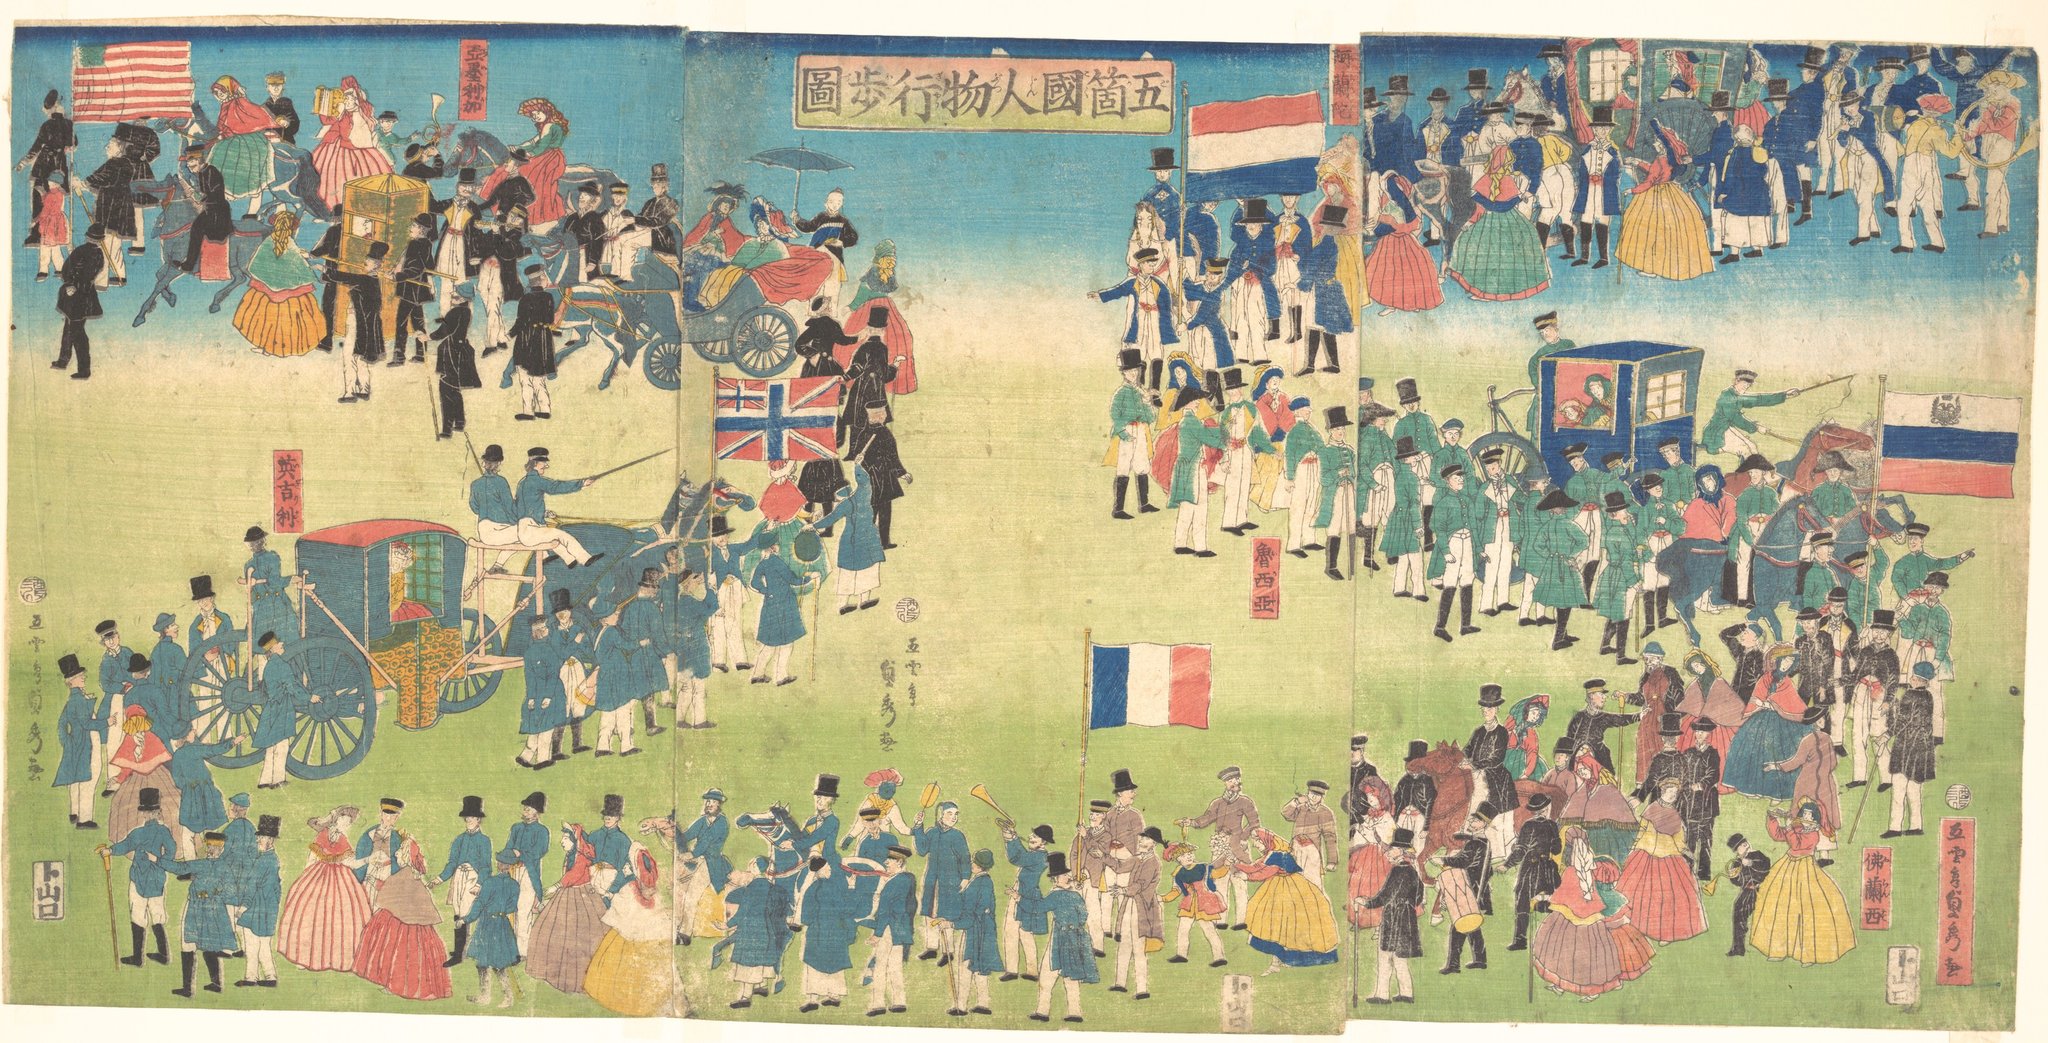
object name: print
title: Procession of People from Five Countries: Holland, Russia, France, England and America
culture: japanese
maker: utagawa (gountei) sadahide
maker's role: artist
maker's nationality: japanese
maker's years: 1807-1873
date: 1861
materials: ink, paper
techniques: woodblock print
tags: crowd,flags,carriages